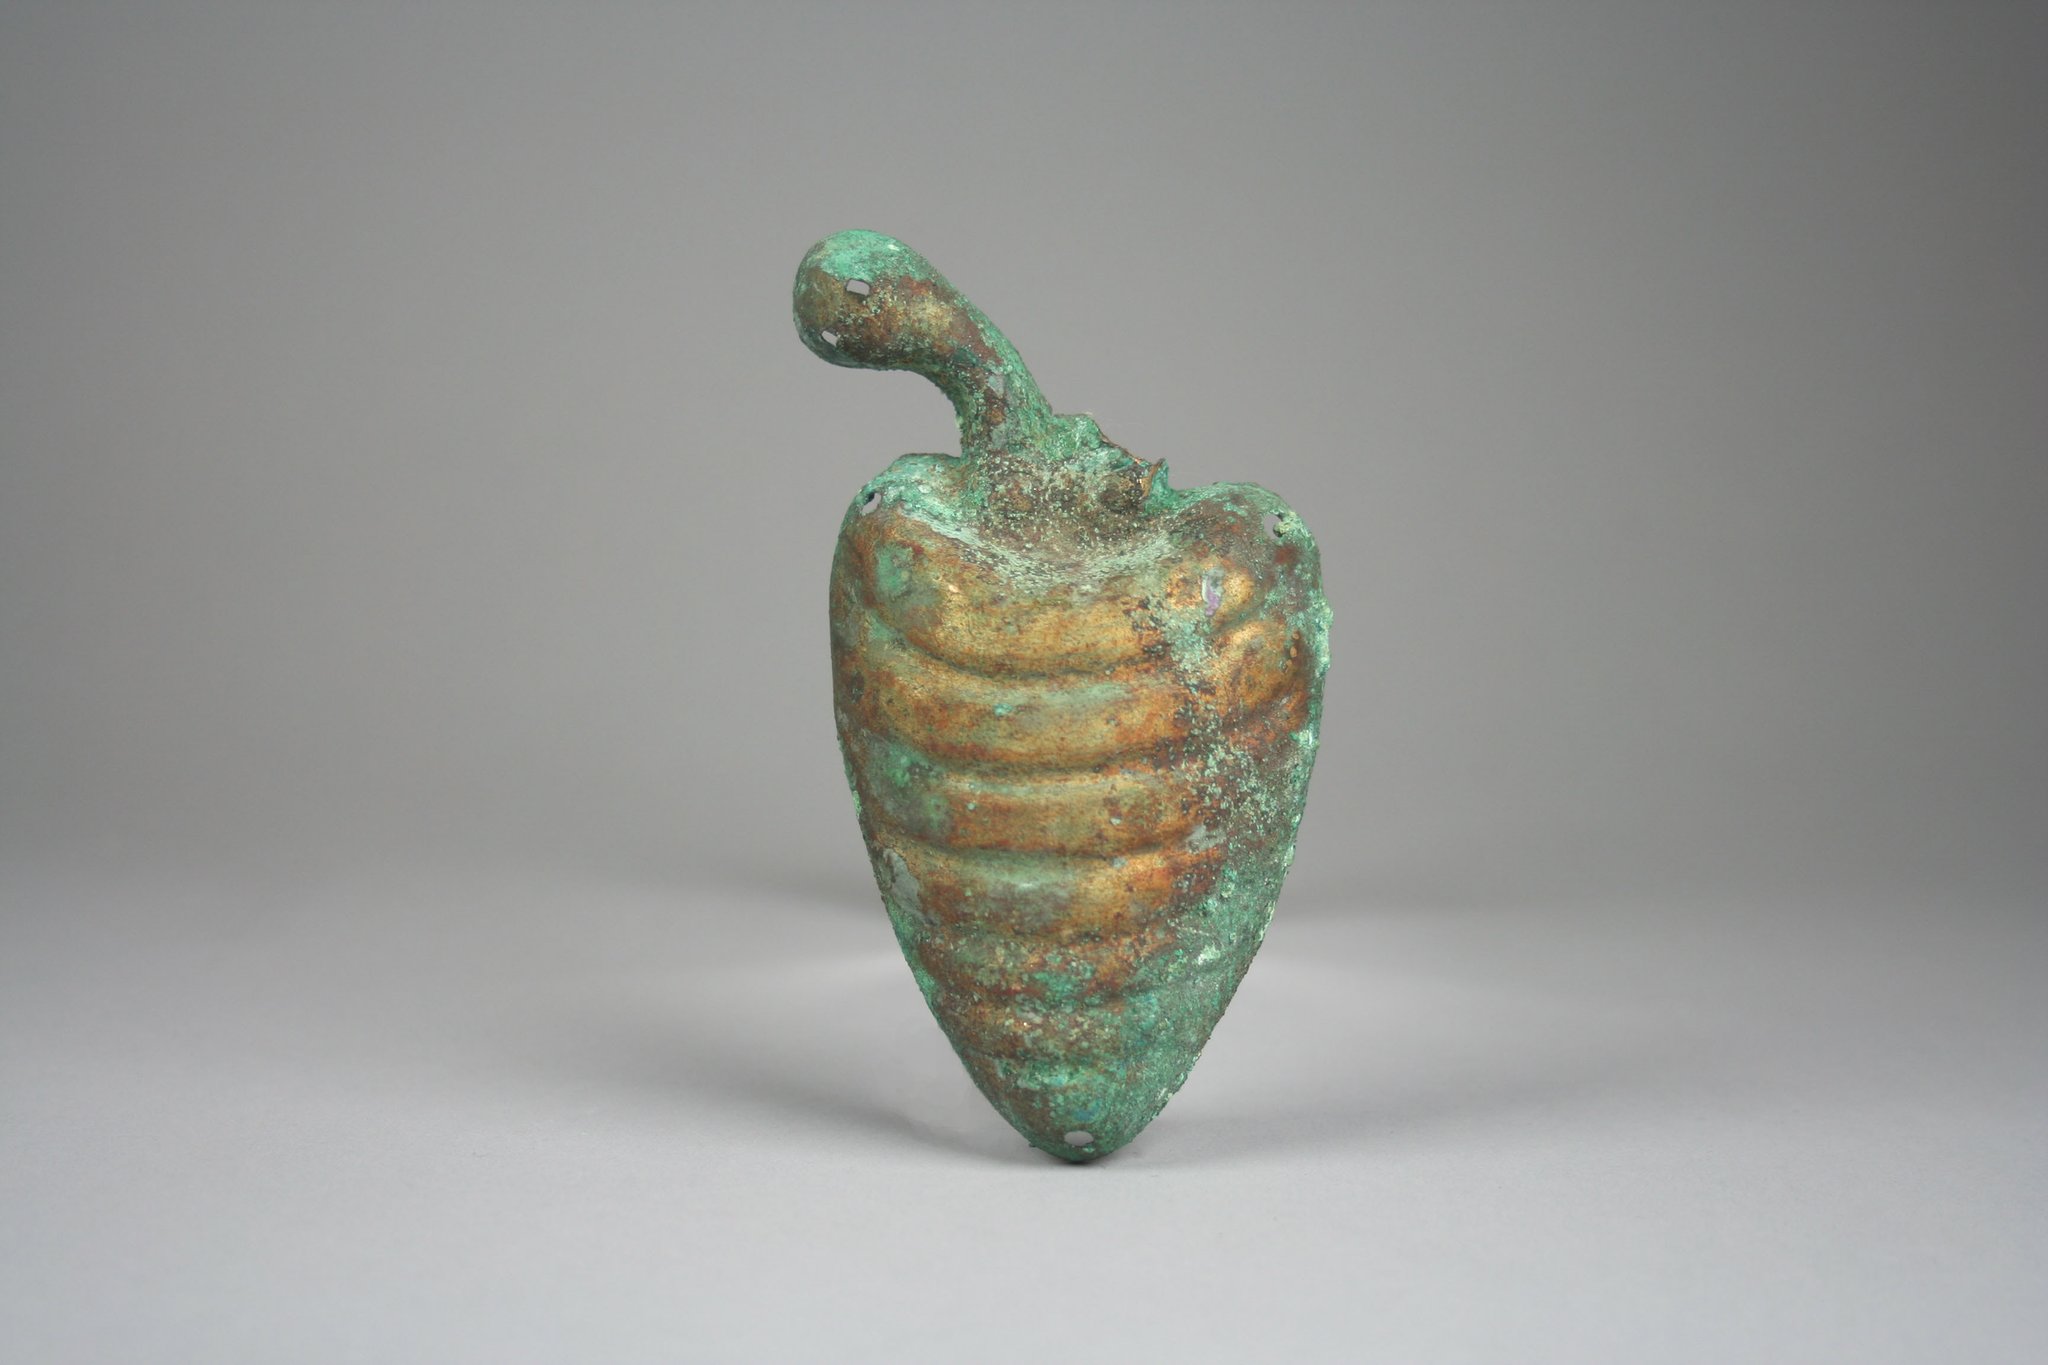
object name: ornament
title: Animal Ornament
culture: moche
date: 501-700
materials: gilt copper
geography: peru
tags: animals